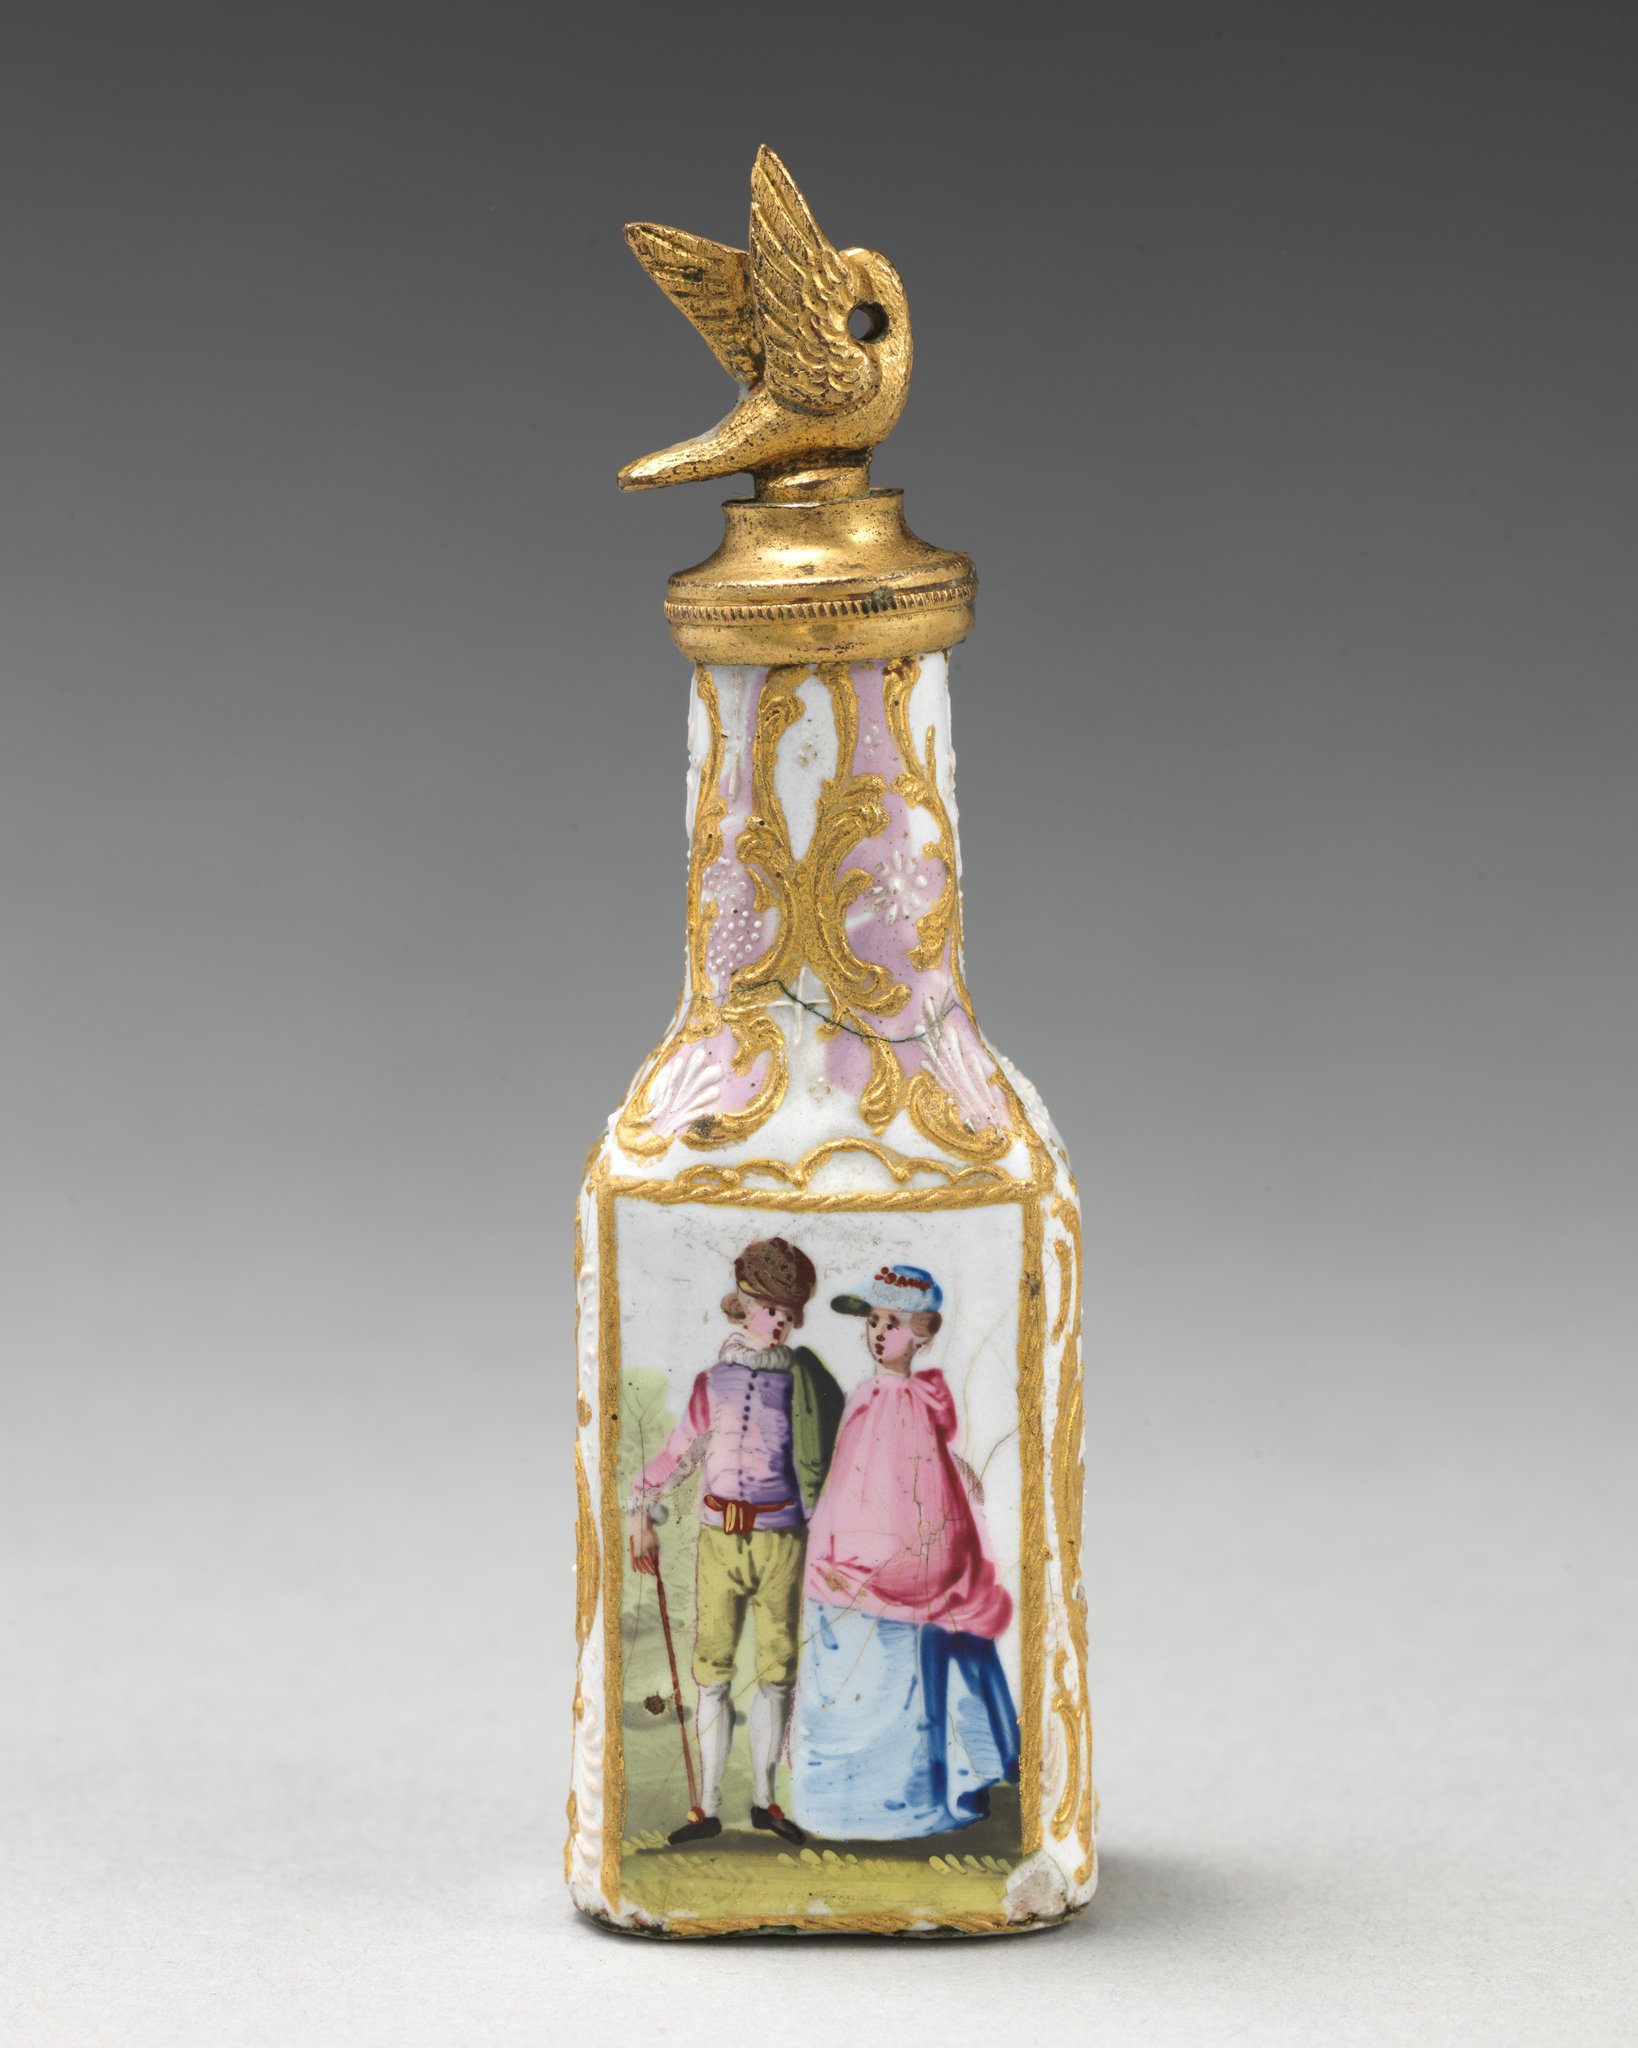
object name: scent bottle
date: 1765-1770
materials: copper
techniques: enamel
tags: birds,men